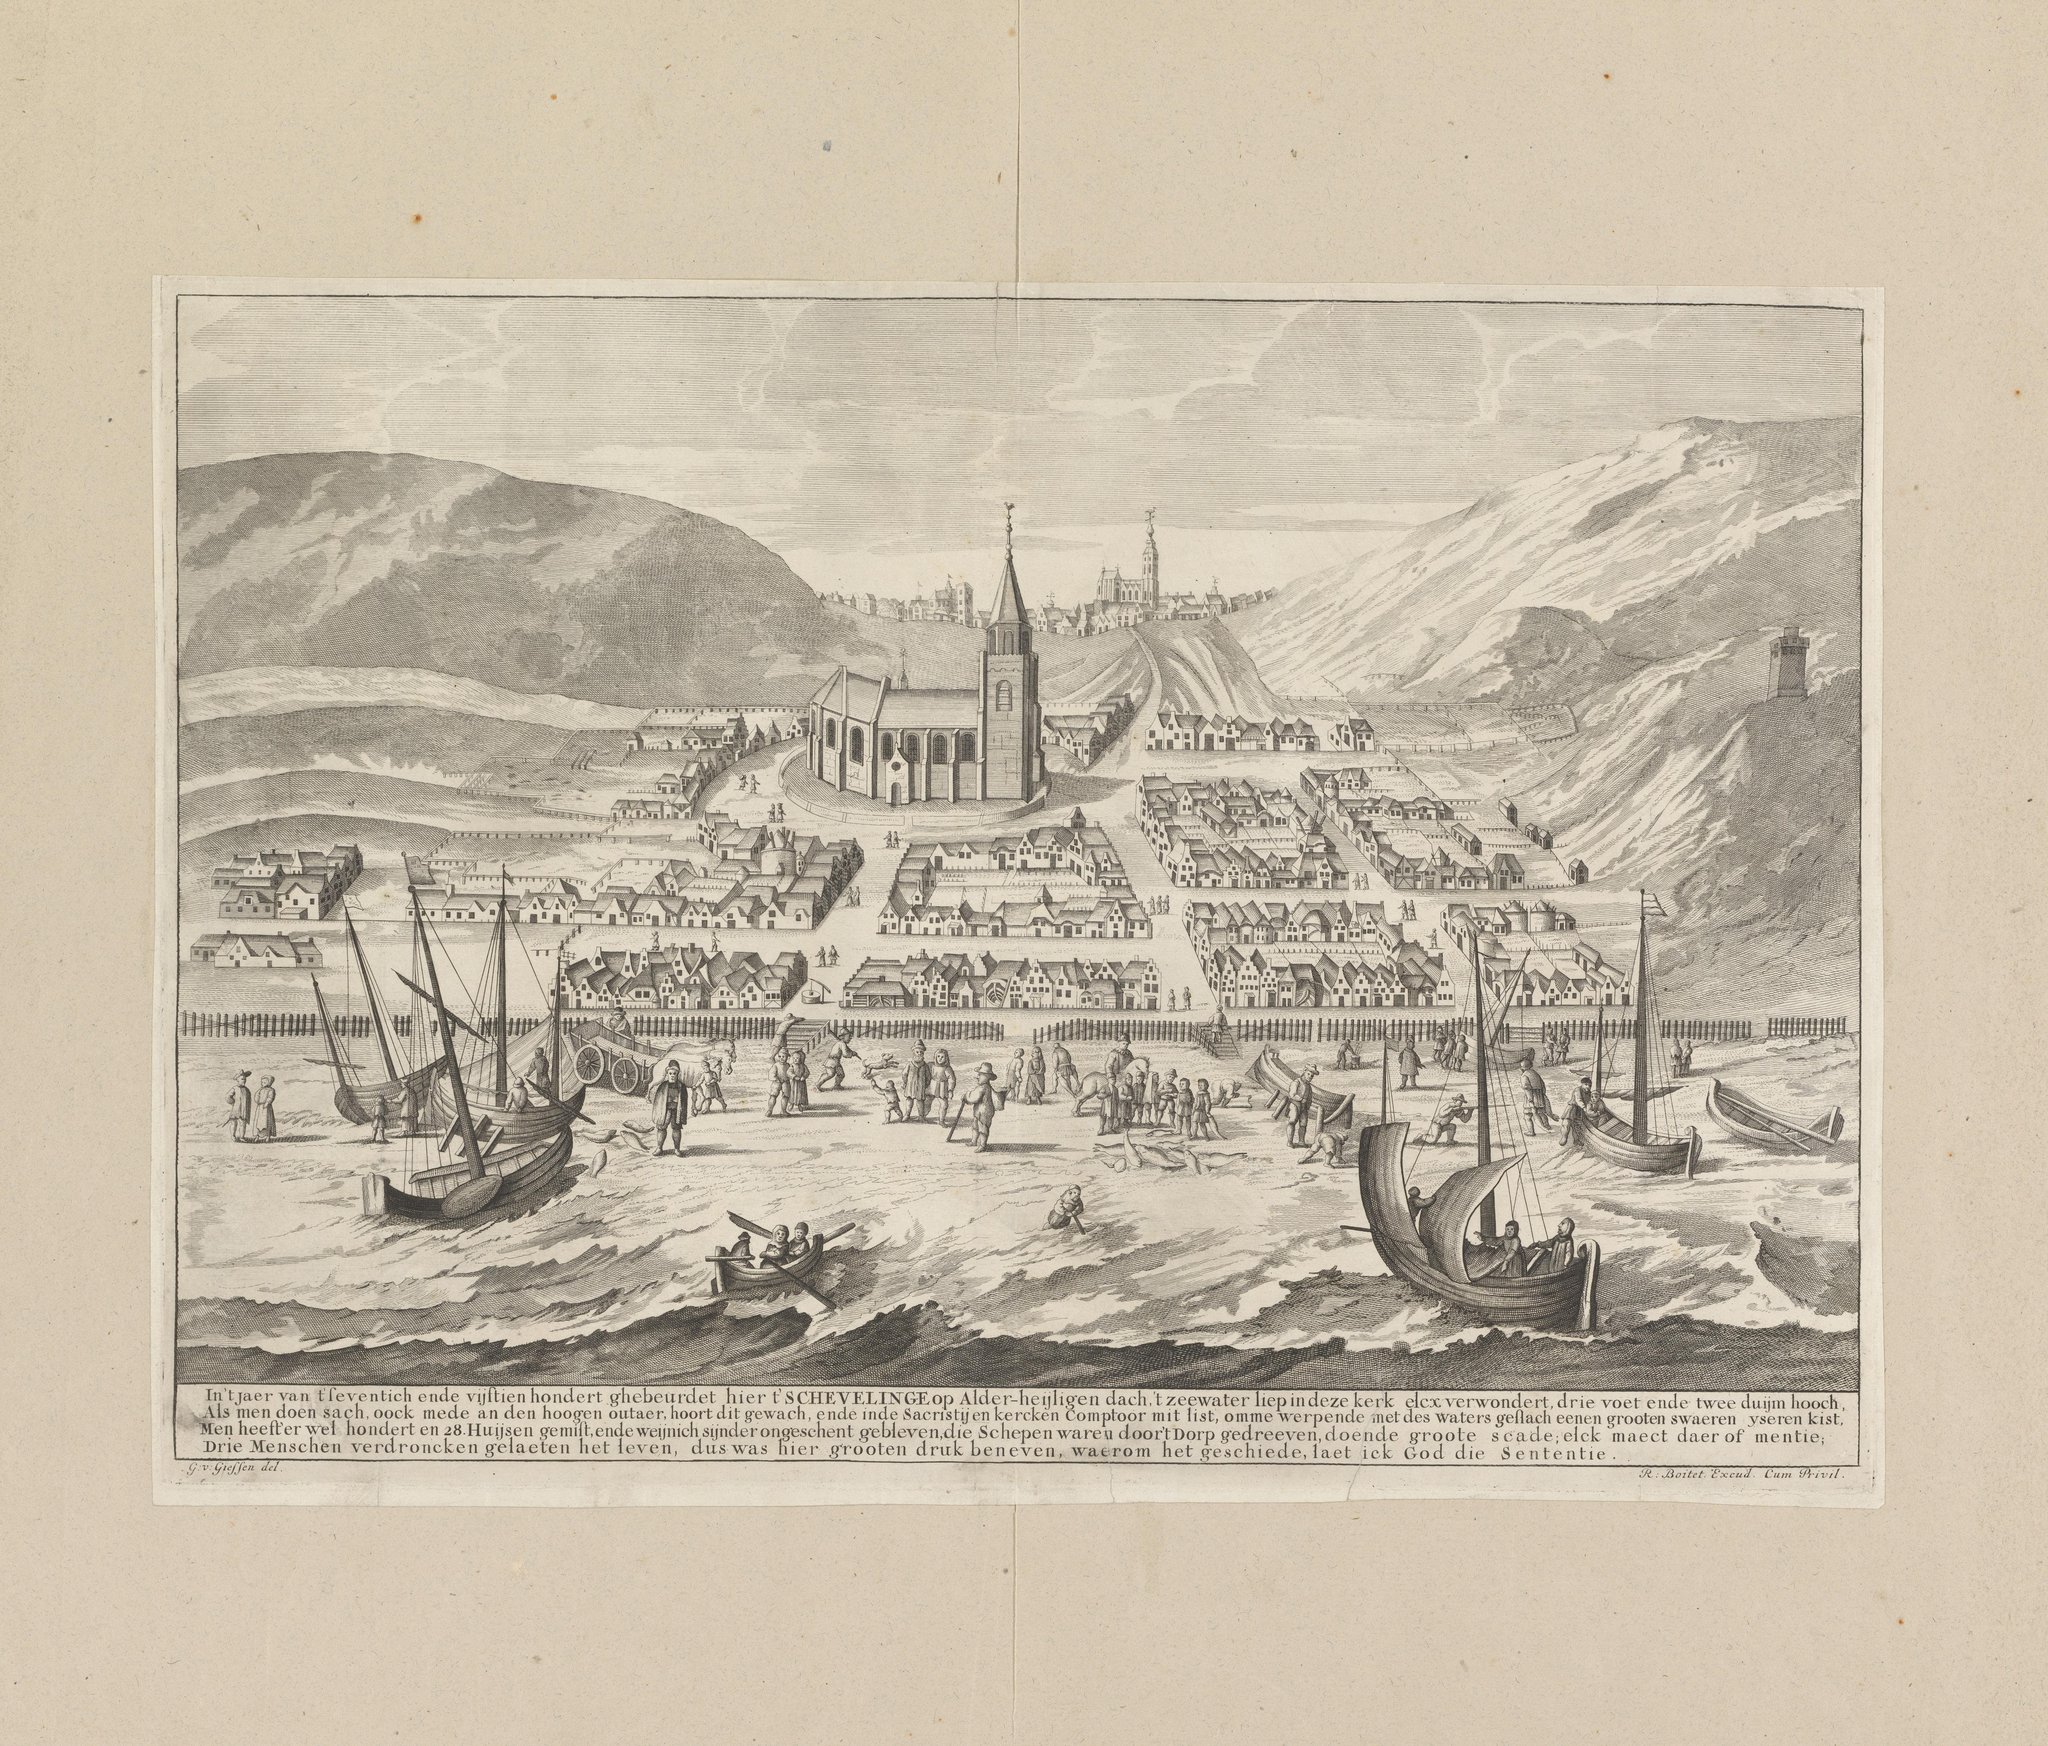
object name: history print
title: Gezicht op Scheveningen vóór de Allerheiligenvloed van 1570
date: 1730-1736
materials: paper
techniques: etching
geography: the hague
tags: prospect of village, silhouette of village, sailing-ship, sailing-boat, church (exterior), prospect of city, town panorama, silhouette of city, beach (+ landscape with figures, staffage), sea, the hague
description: Gezicht op het dorp Scheveningen voordat het getroffen werd door een stormvloed op Allerheiligen, 1 november 1570. Hierbij werden 128 huizen verwoest en verdronken drie personen. Op de voorgrond de zee en het strand. Daarachter het dorp, gelegen tussen de duinen, met in het midden de kerk. Op de achtergrond Den Haag. Met een vierregelig onderschrift in het Nederlands.